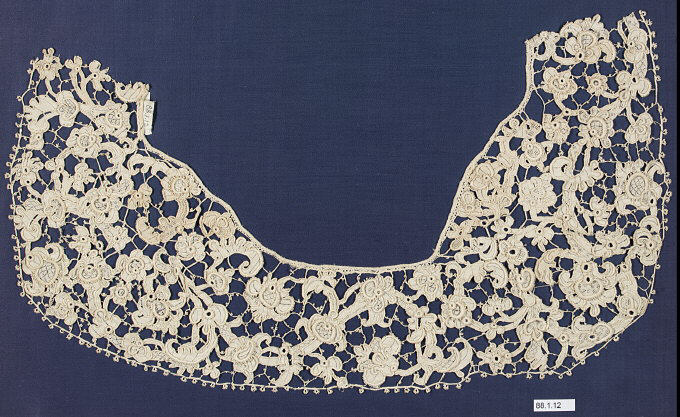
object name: collar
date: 1650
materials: lace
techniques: gros point, lace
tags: flowers